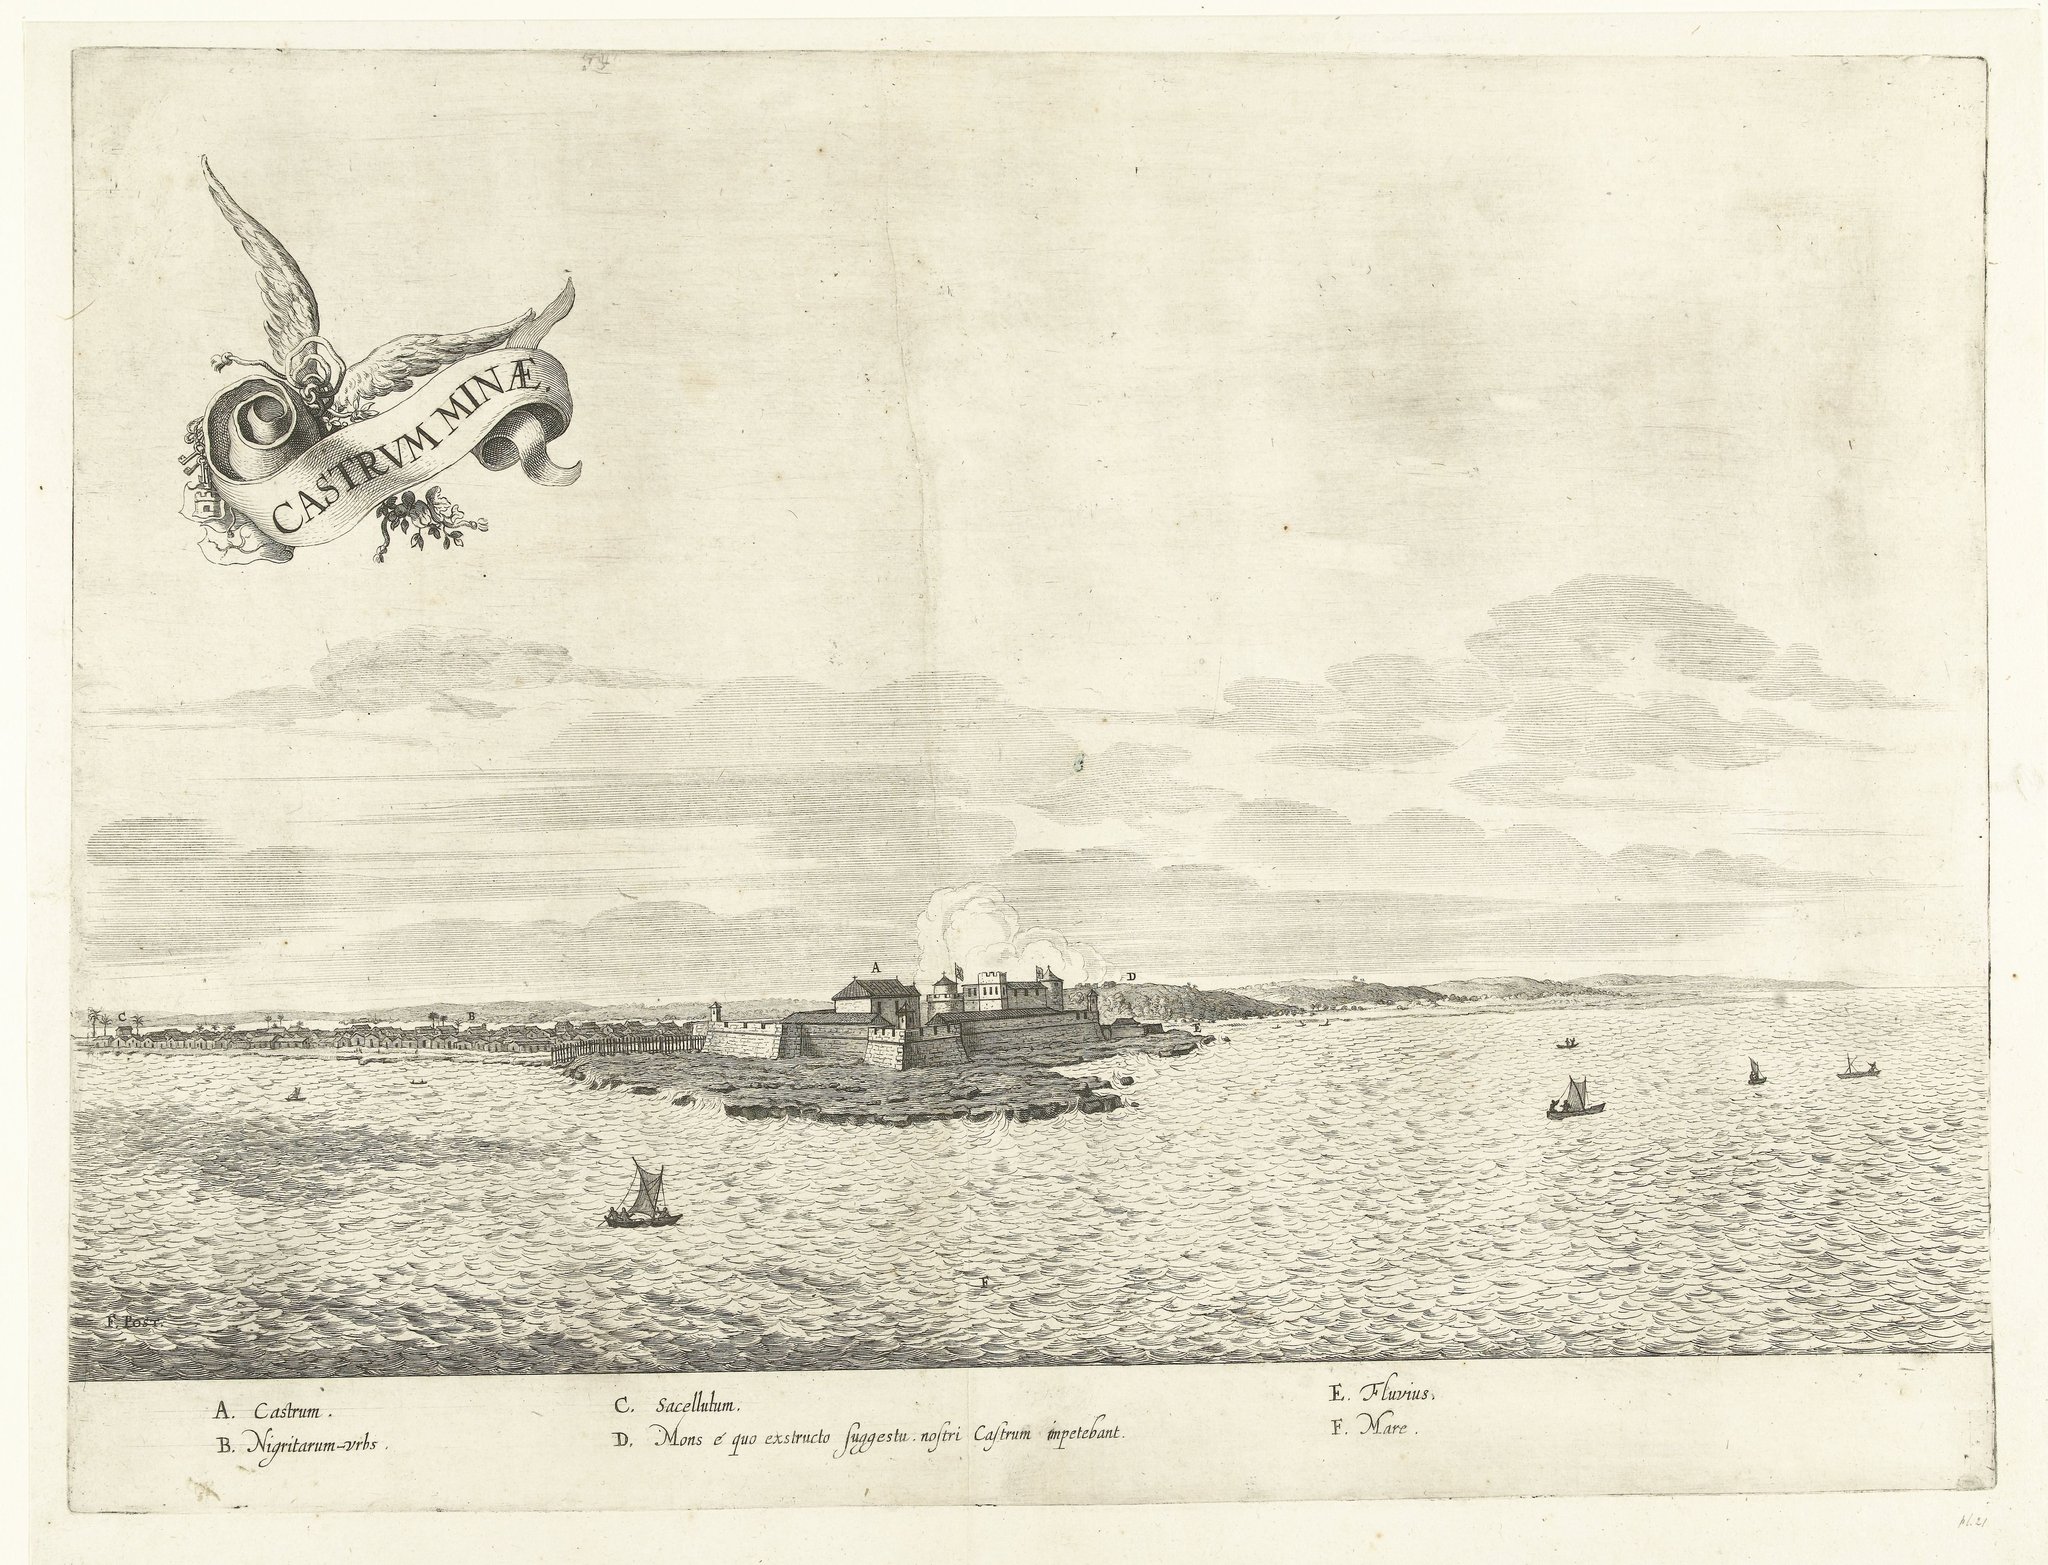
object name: print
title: Gezicht op het Fort Elmina, ca. 1636-1644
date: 1645-1647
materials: paper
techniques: engraving, etching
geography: netherlands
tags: earl, johan maurits graaf van nassau-siegen, fortress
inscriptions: collector's mark: Lugt 2228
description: Prent gebruikt voor: Caspar Barlaeus, Rerum per octennium in Brasilia et alibi nuper gestarum sub praefectura J. Mauritii, Nassoviae, c. comitis... historia, Amsterdam, uitgever Joannes Blaeu, 1647, na p. 56, pl. 21